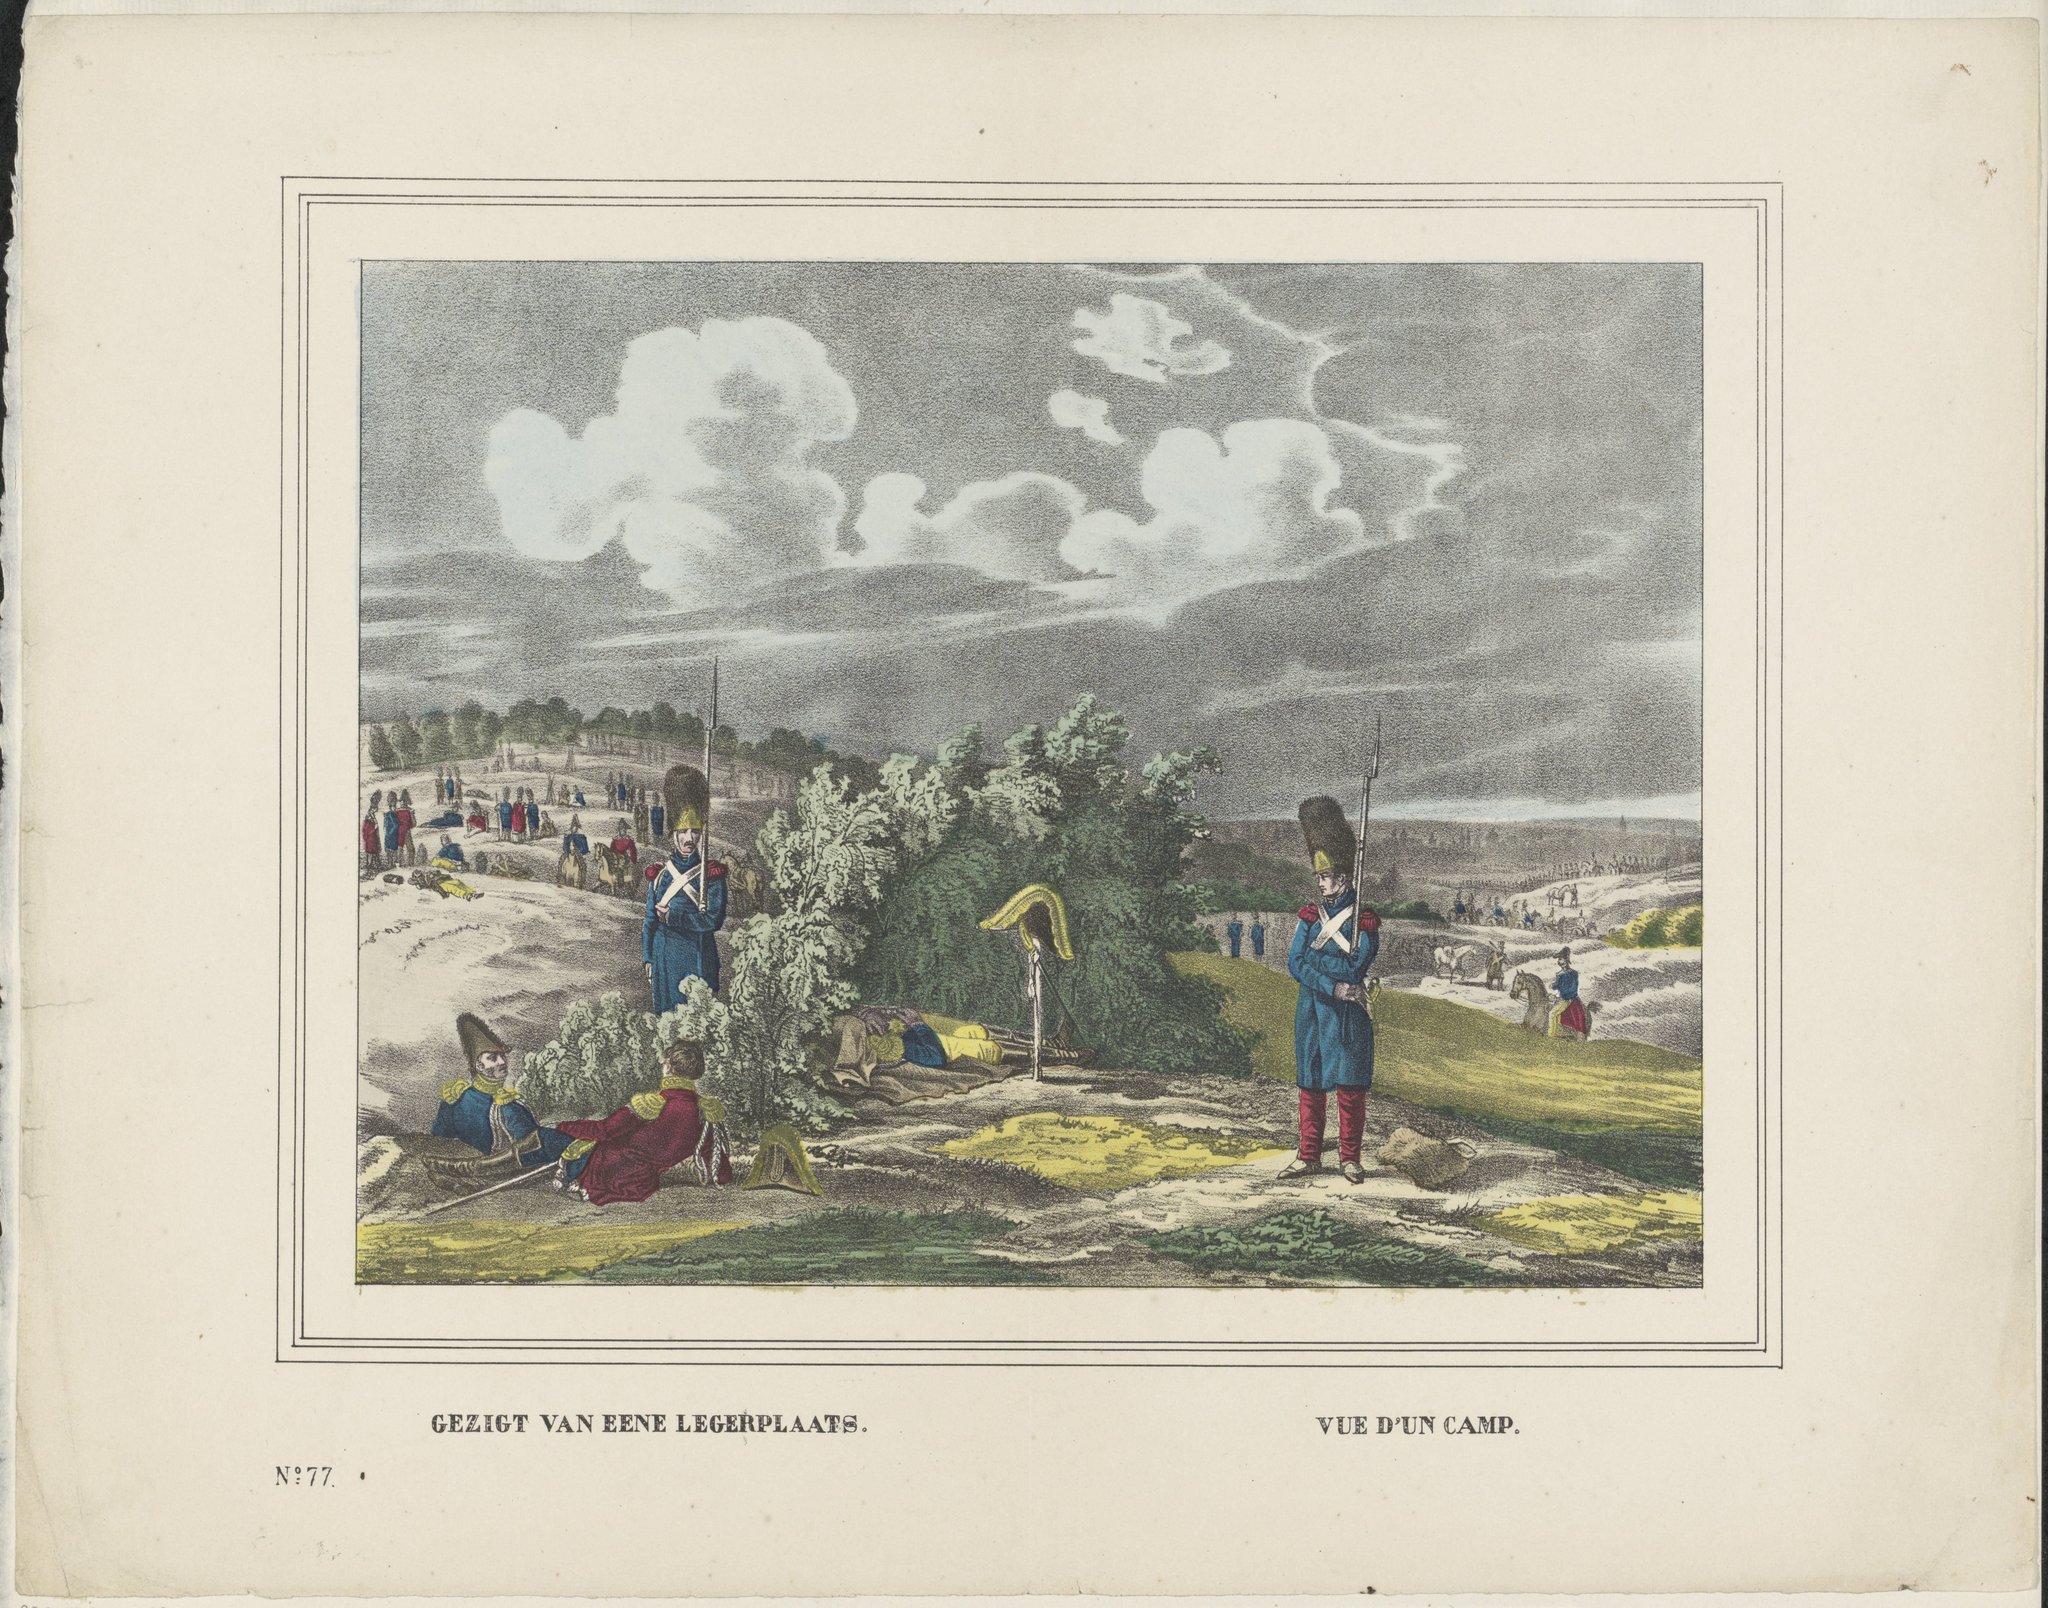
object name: popular print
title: Gezigt van eene legerplaats / Vue d'un camp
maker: Anonymous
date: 1833-1856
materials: paper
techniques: colour, letterpress printing, lithograph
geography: turnhout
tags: shelter ~ military service (+ land forces), the soldier; the soldier's life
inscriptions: collector's mark: Lugt 2760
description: Blad met een grote voorstelling van een legerplaats met militairen. Onder de voorstelling de titel. Genummerd linksonder: No. 77.